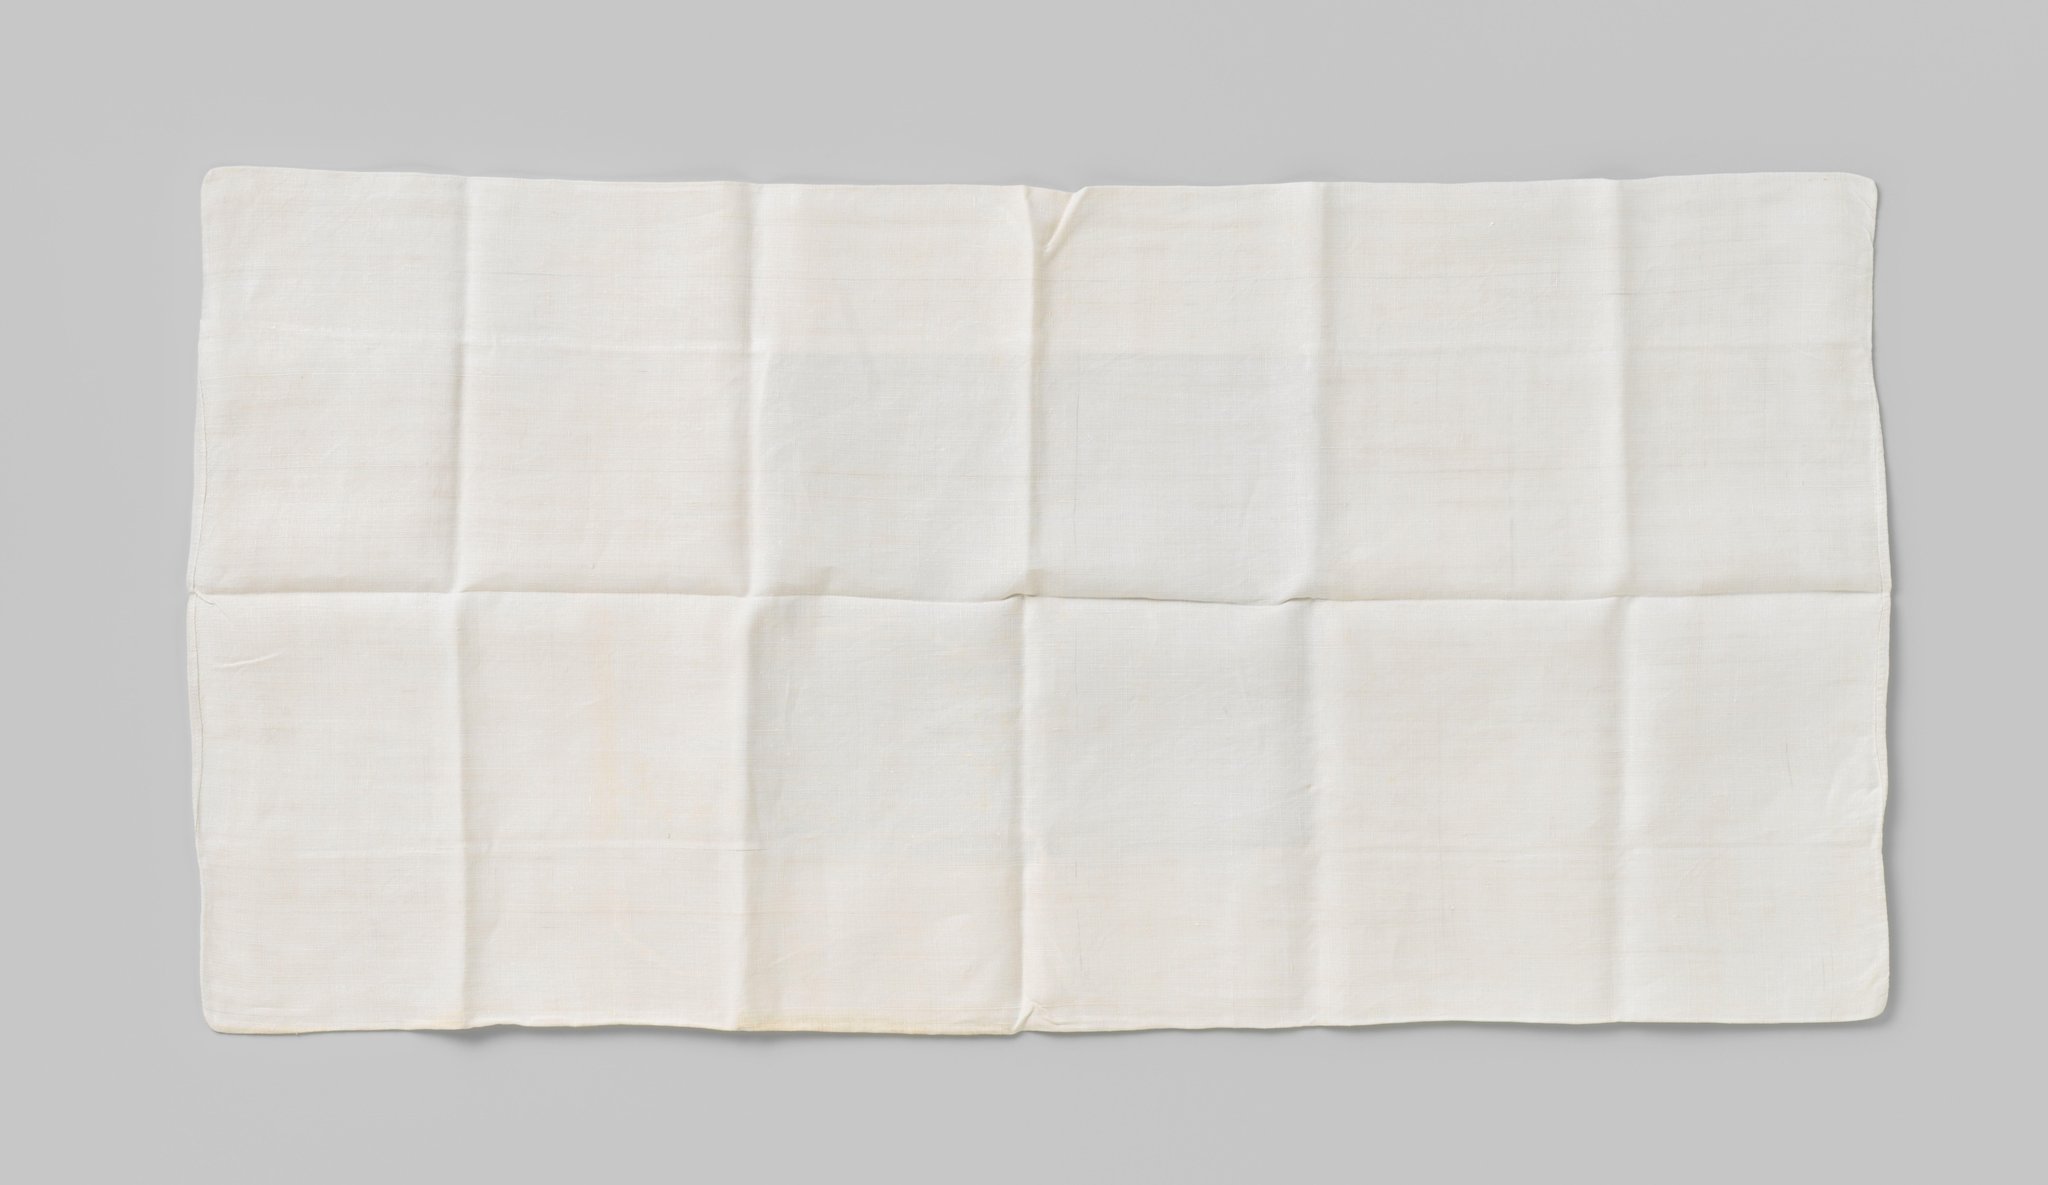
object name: bolster case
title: Peluwsloop met opening in het midden en twee sluitbandjes, gemerkt WG16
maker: Anonymous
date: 1726-1769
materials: linen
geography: northern netherlands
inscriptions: mark: ‘WG 16’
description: Peluwsloop van linnen met opening in het midden en twee sluitbandjes, gemerkt WG16.